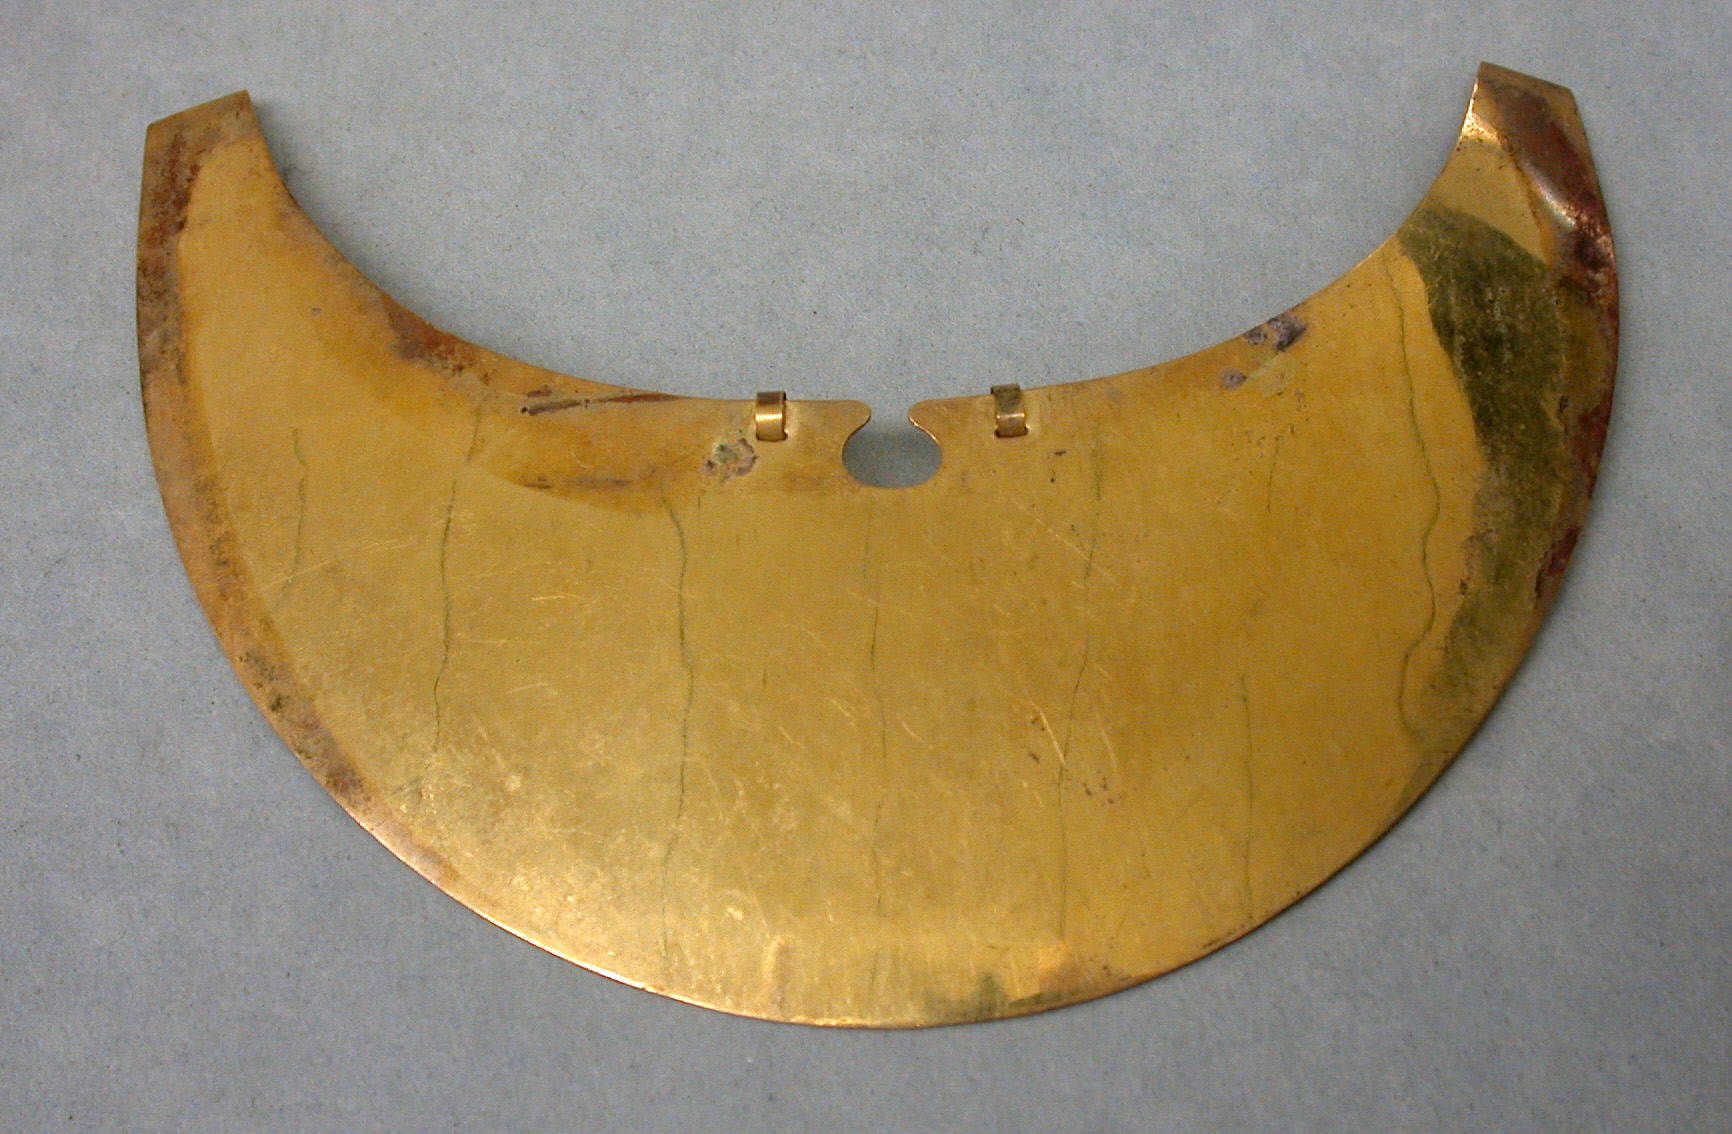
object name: nose ornament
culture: moche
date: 1-300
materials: gold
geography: peru